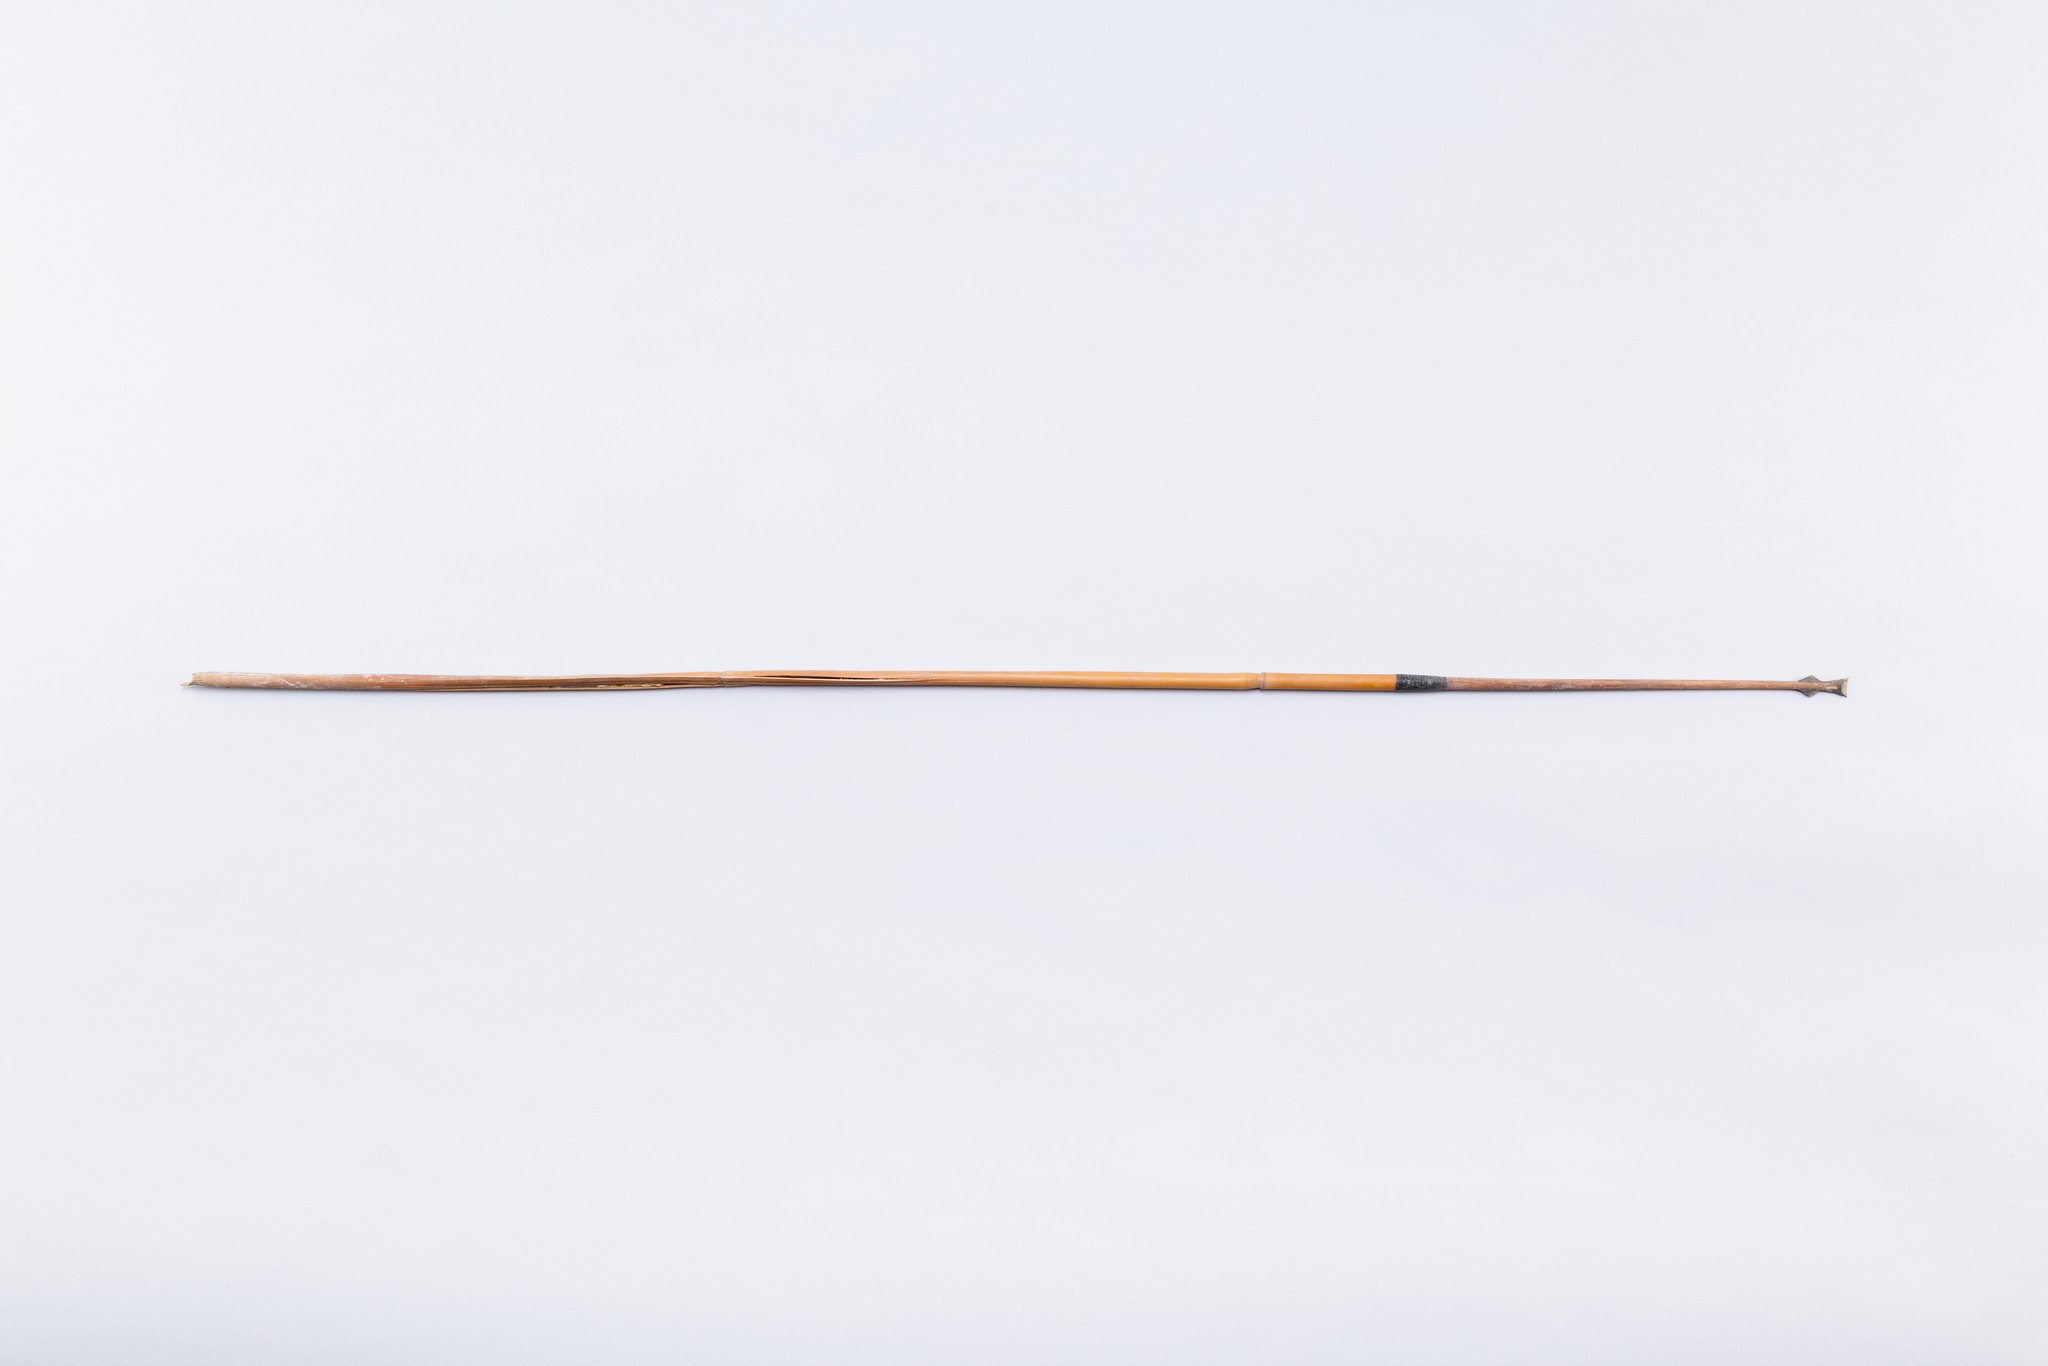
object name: arrow, arrowhead, adhesive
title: Arrow with composite stone tip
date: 1479-1458 BCE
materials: quartz, wood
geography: egypt